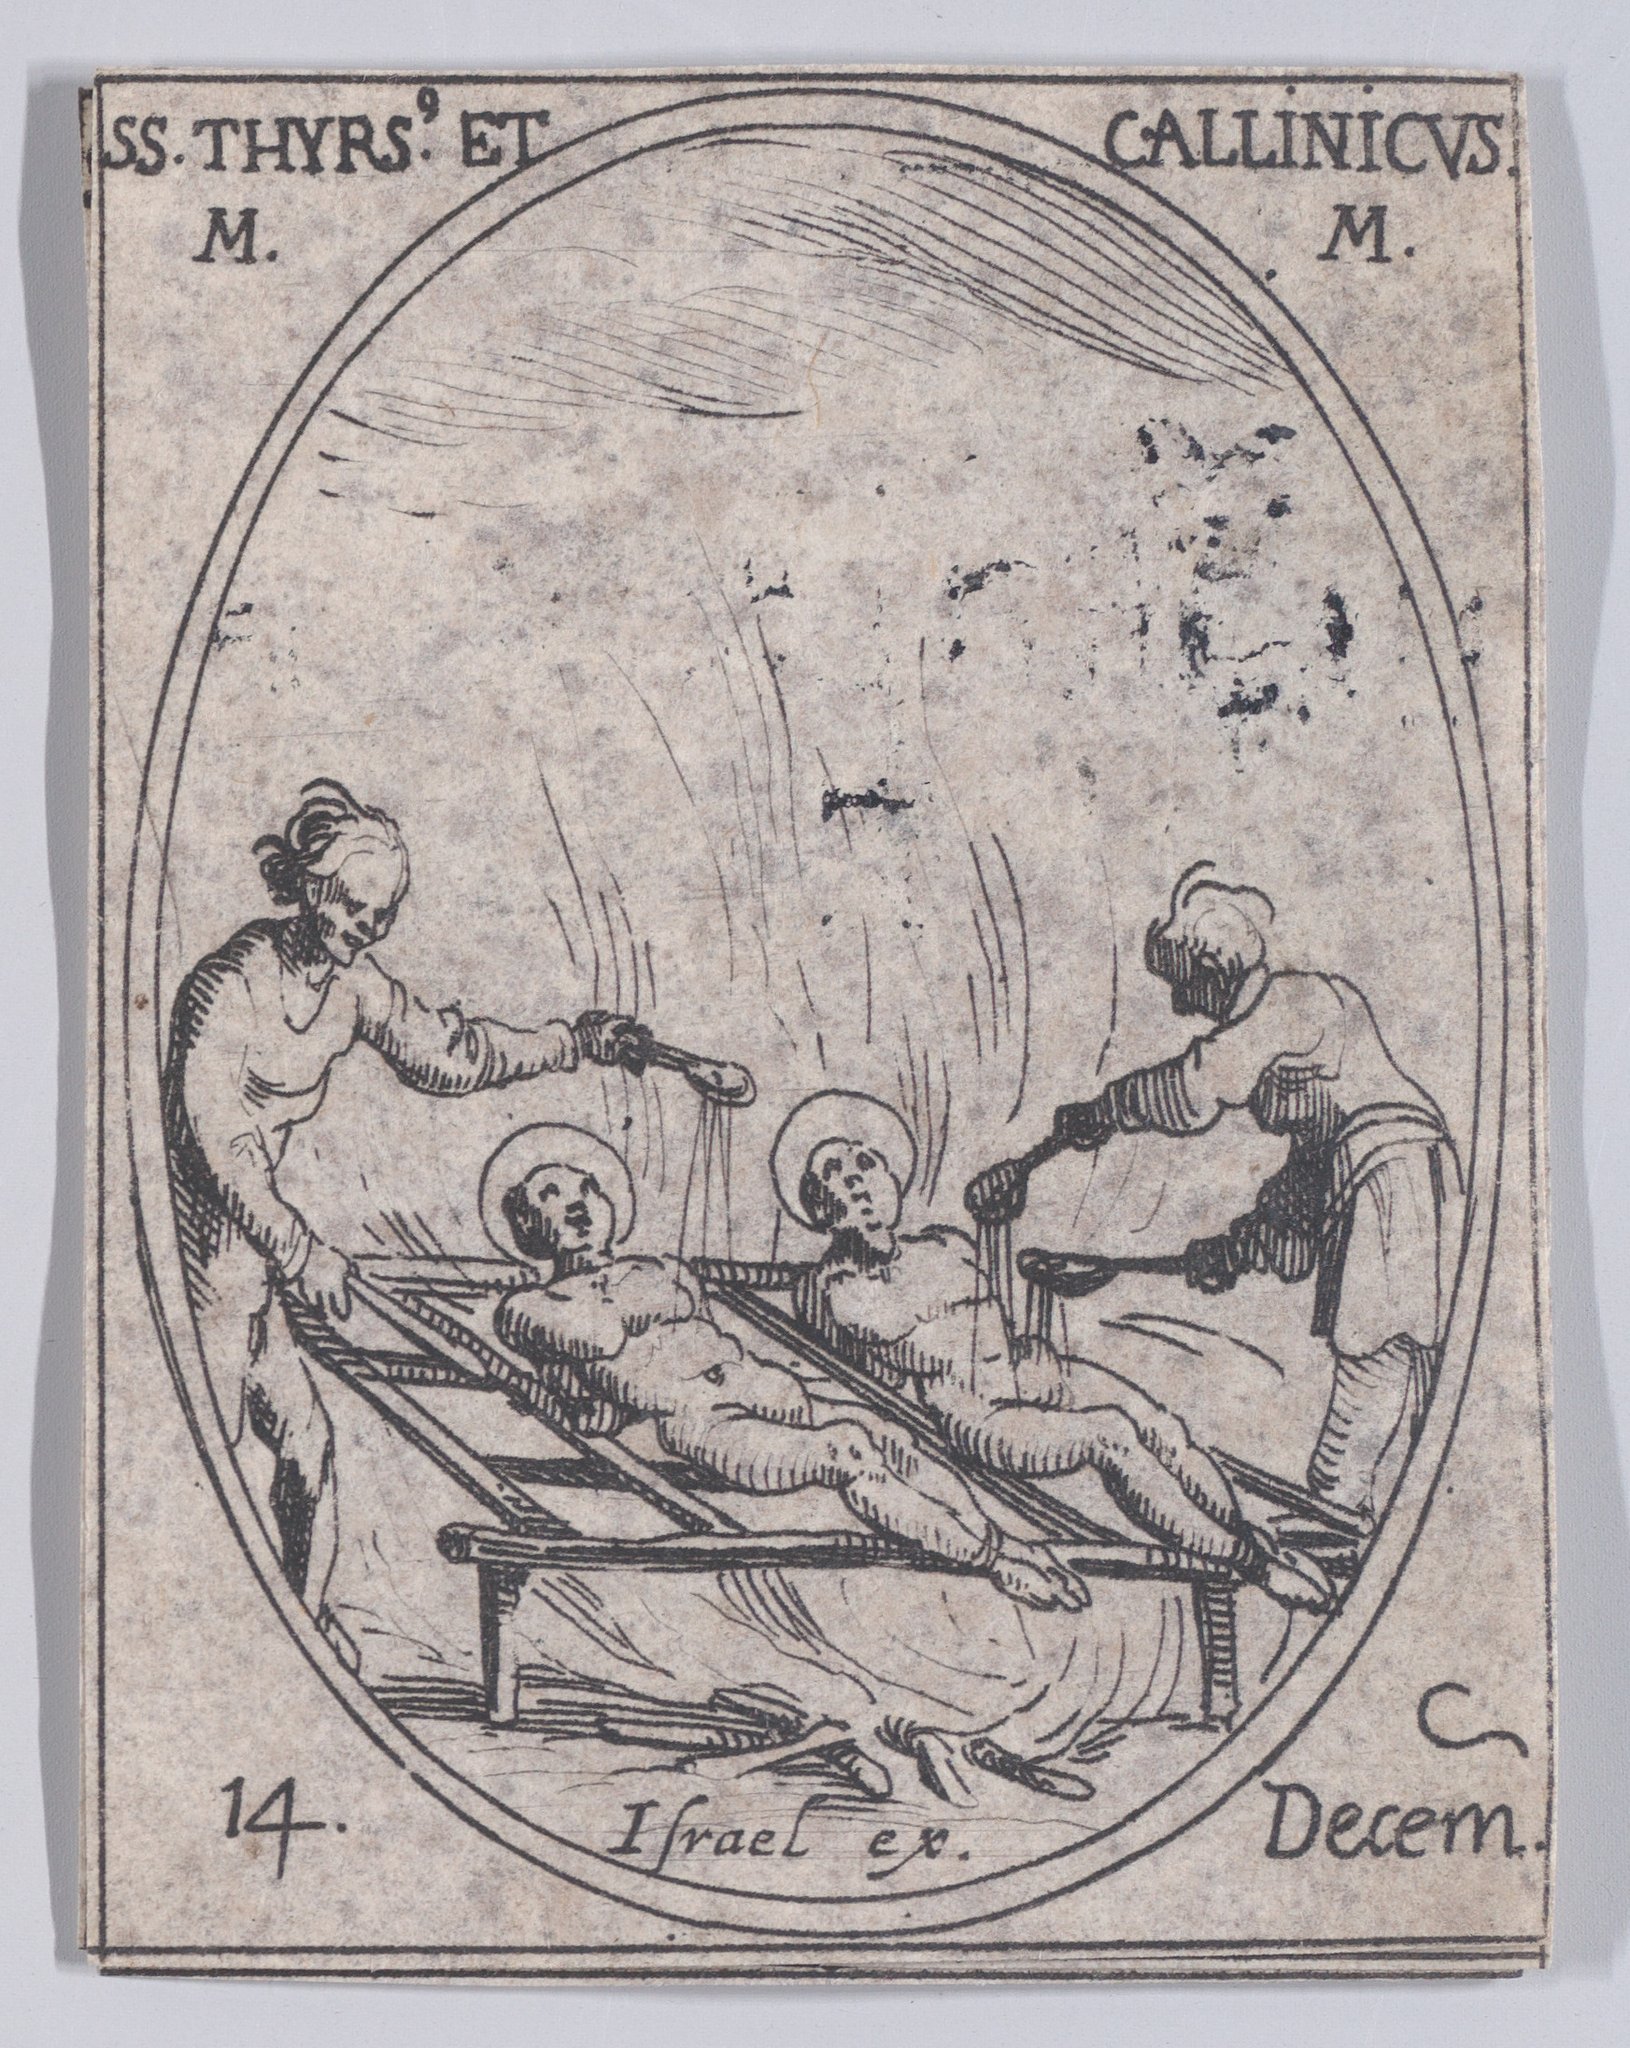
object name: print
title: S. Thyrse et S. Callinique (St. Thyrsus and St. Callinicus), December 14th, from "Les Images De Tous Les Saincts et Saintes de L'Année" (Images of All of the Saints and Religious Events of the Year)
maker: jacques callot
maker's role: artist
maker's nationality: french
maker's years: 1592-1635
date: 1636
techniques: etching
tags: men,saints